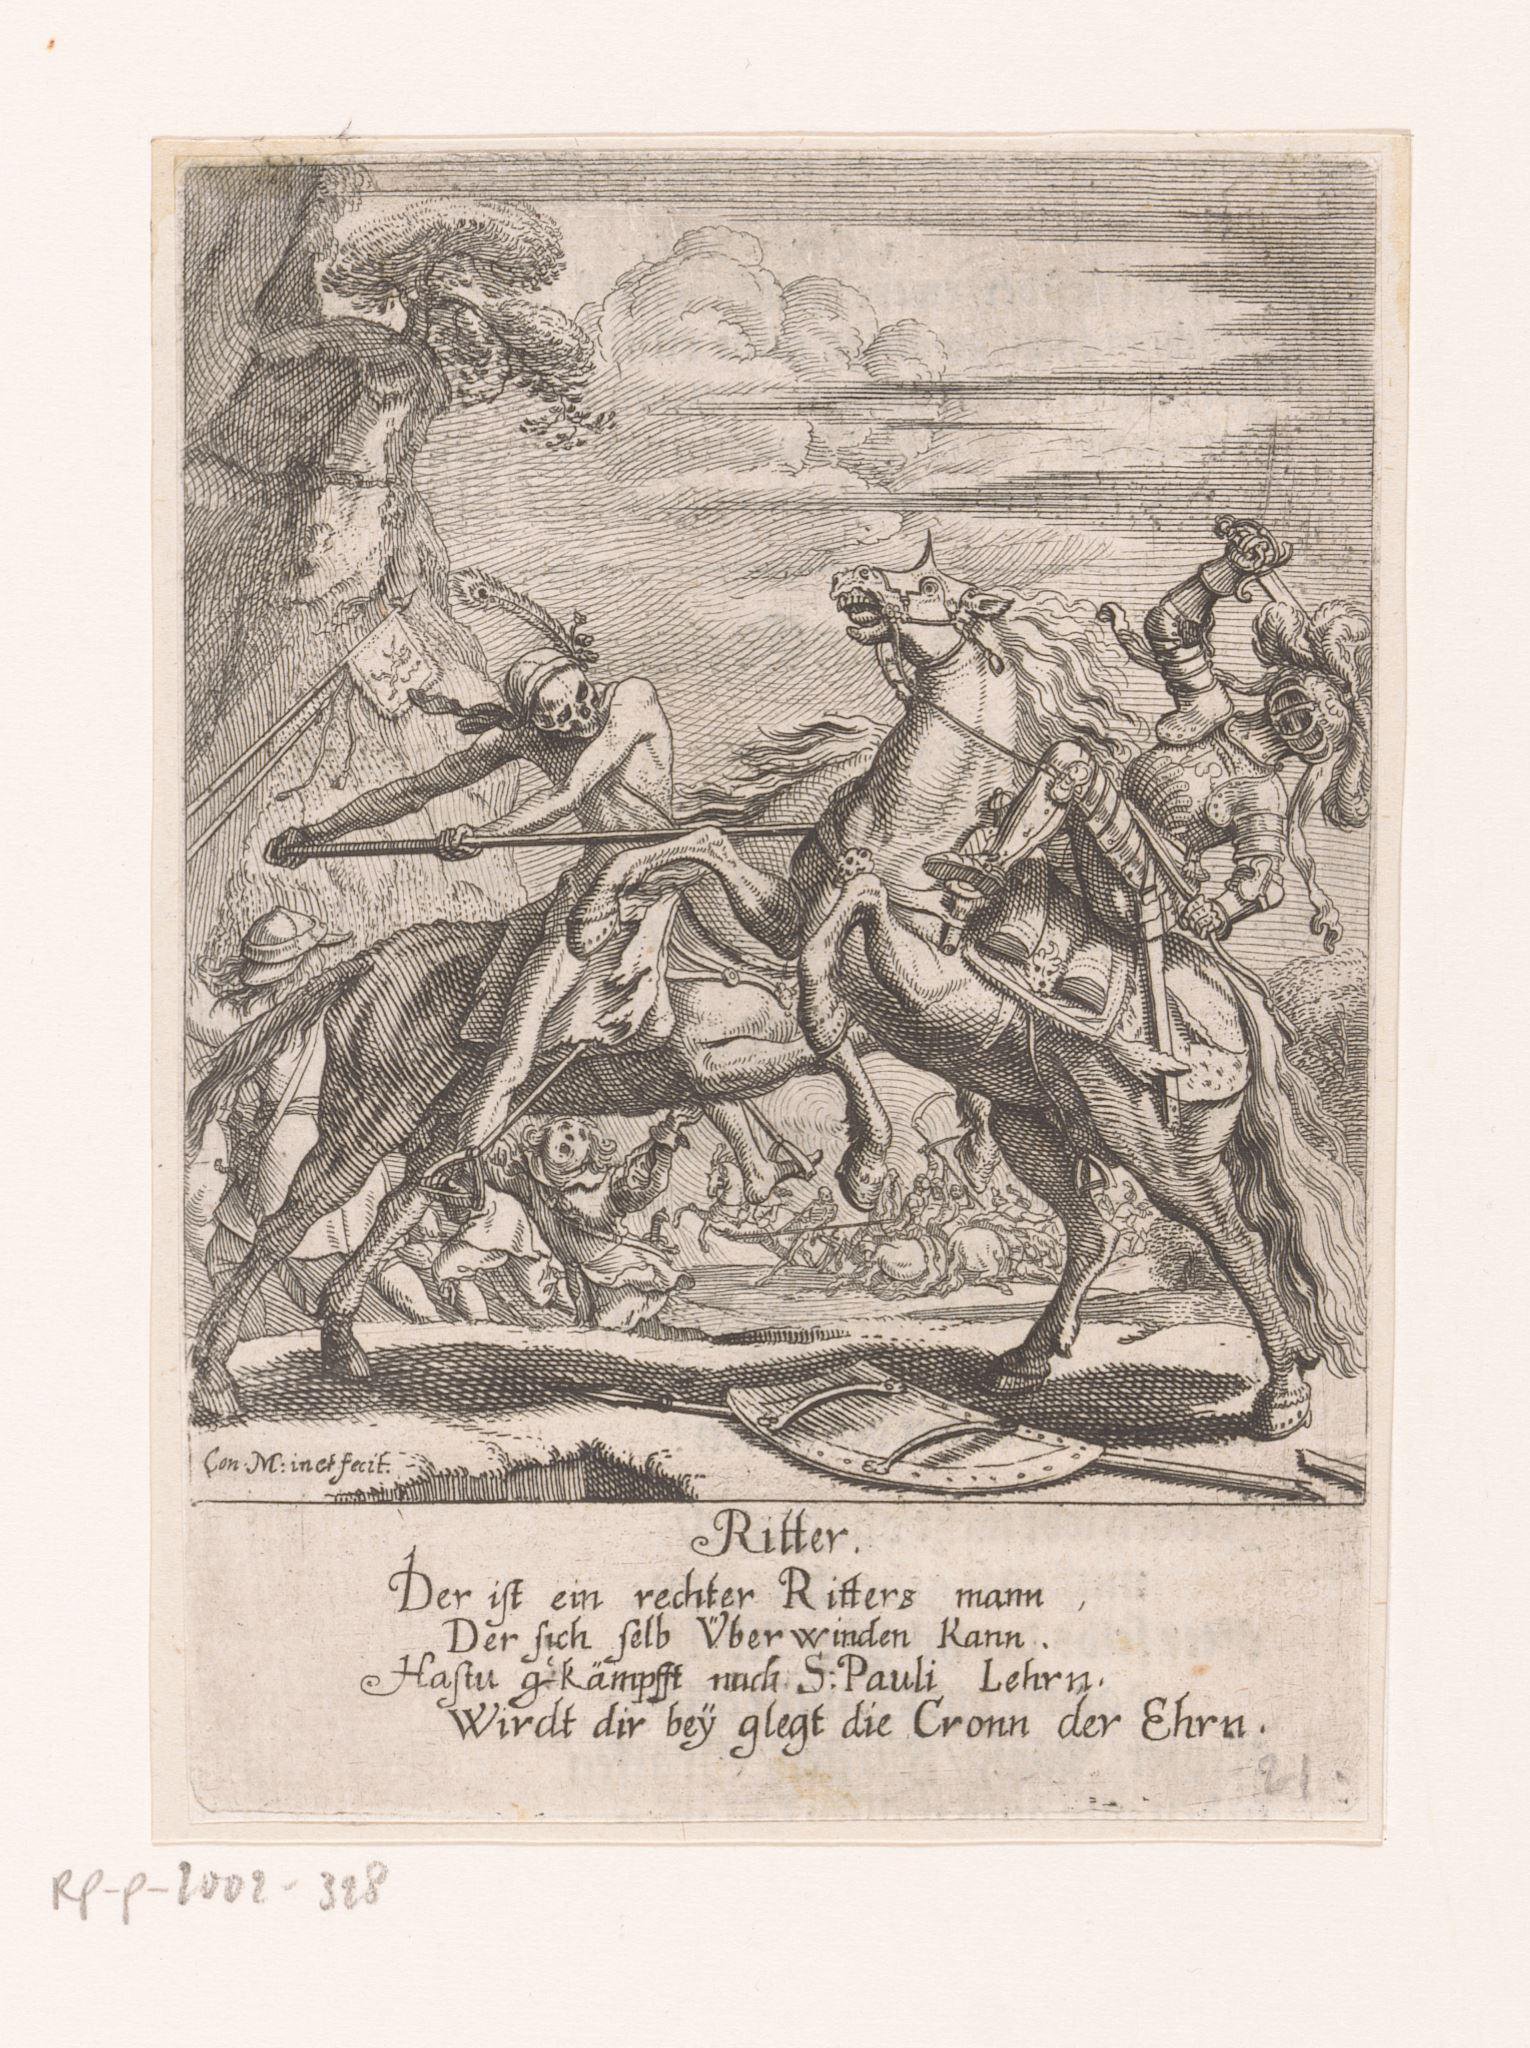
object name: print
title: De Dodendans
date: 1650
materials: paper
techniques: etching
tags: personifications of death; 'morte' (ripa), dance of death; death together with one or more human beings, knight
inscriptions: collector's mark: Lugt 2233, collector's mark: Lugt 2228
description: Prent uit: Meyer, Rudolph. Sterbenspiegel, das ist sonnenklare Vorstellung menschlicher Nichtigkeit durch alle Ständ und Geschlechter (...). Zürich: J.J. Bodmer, 1650.